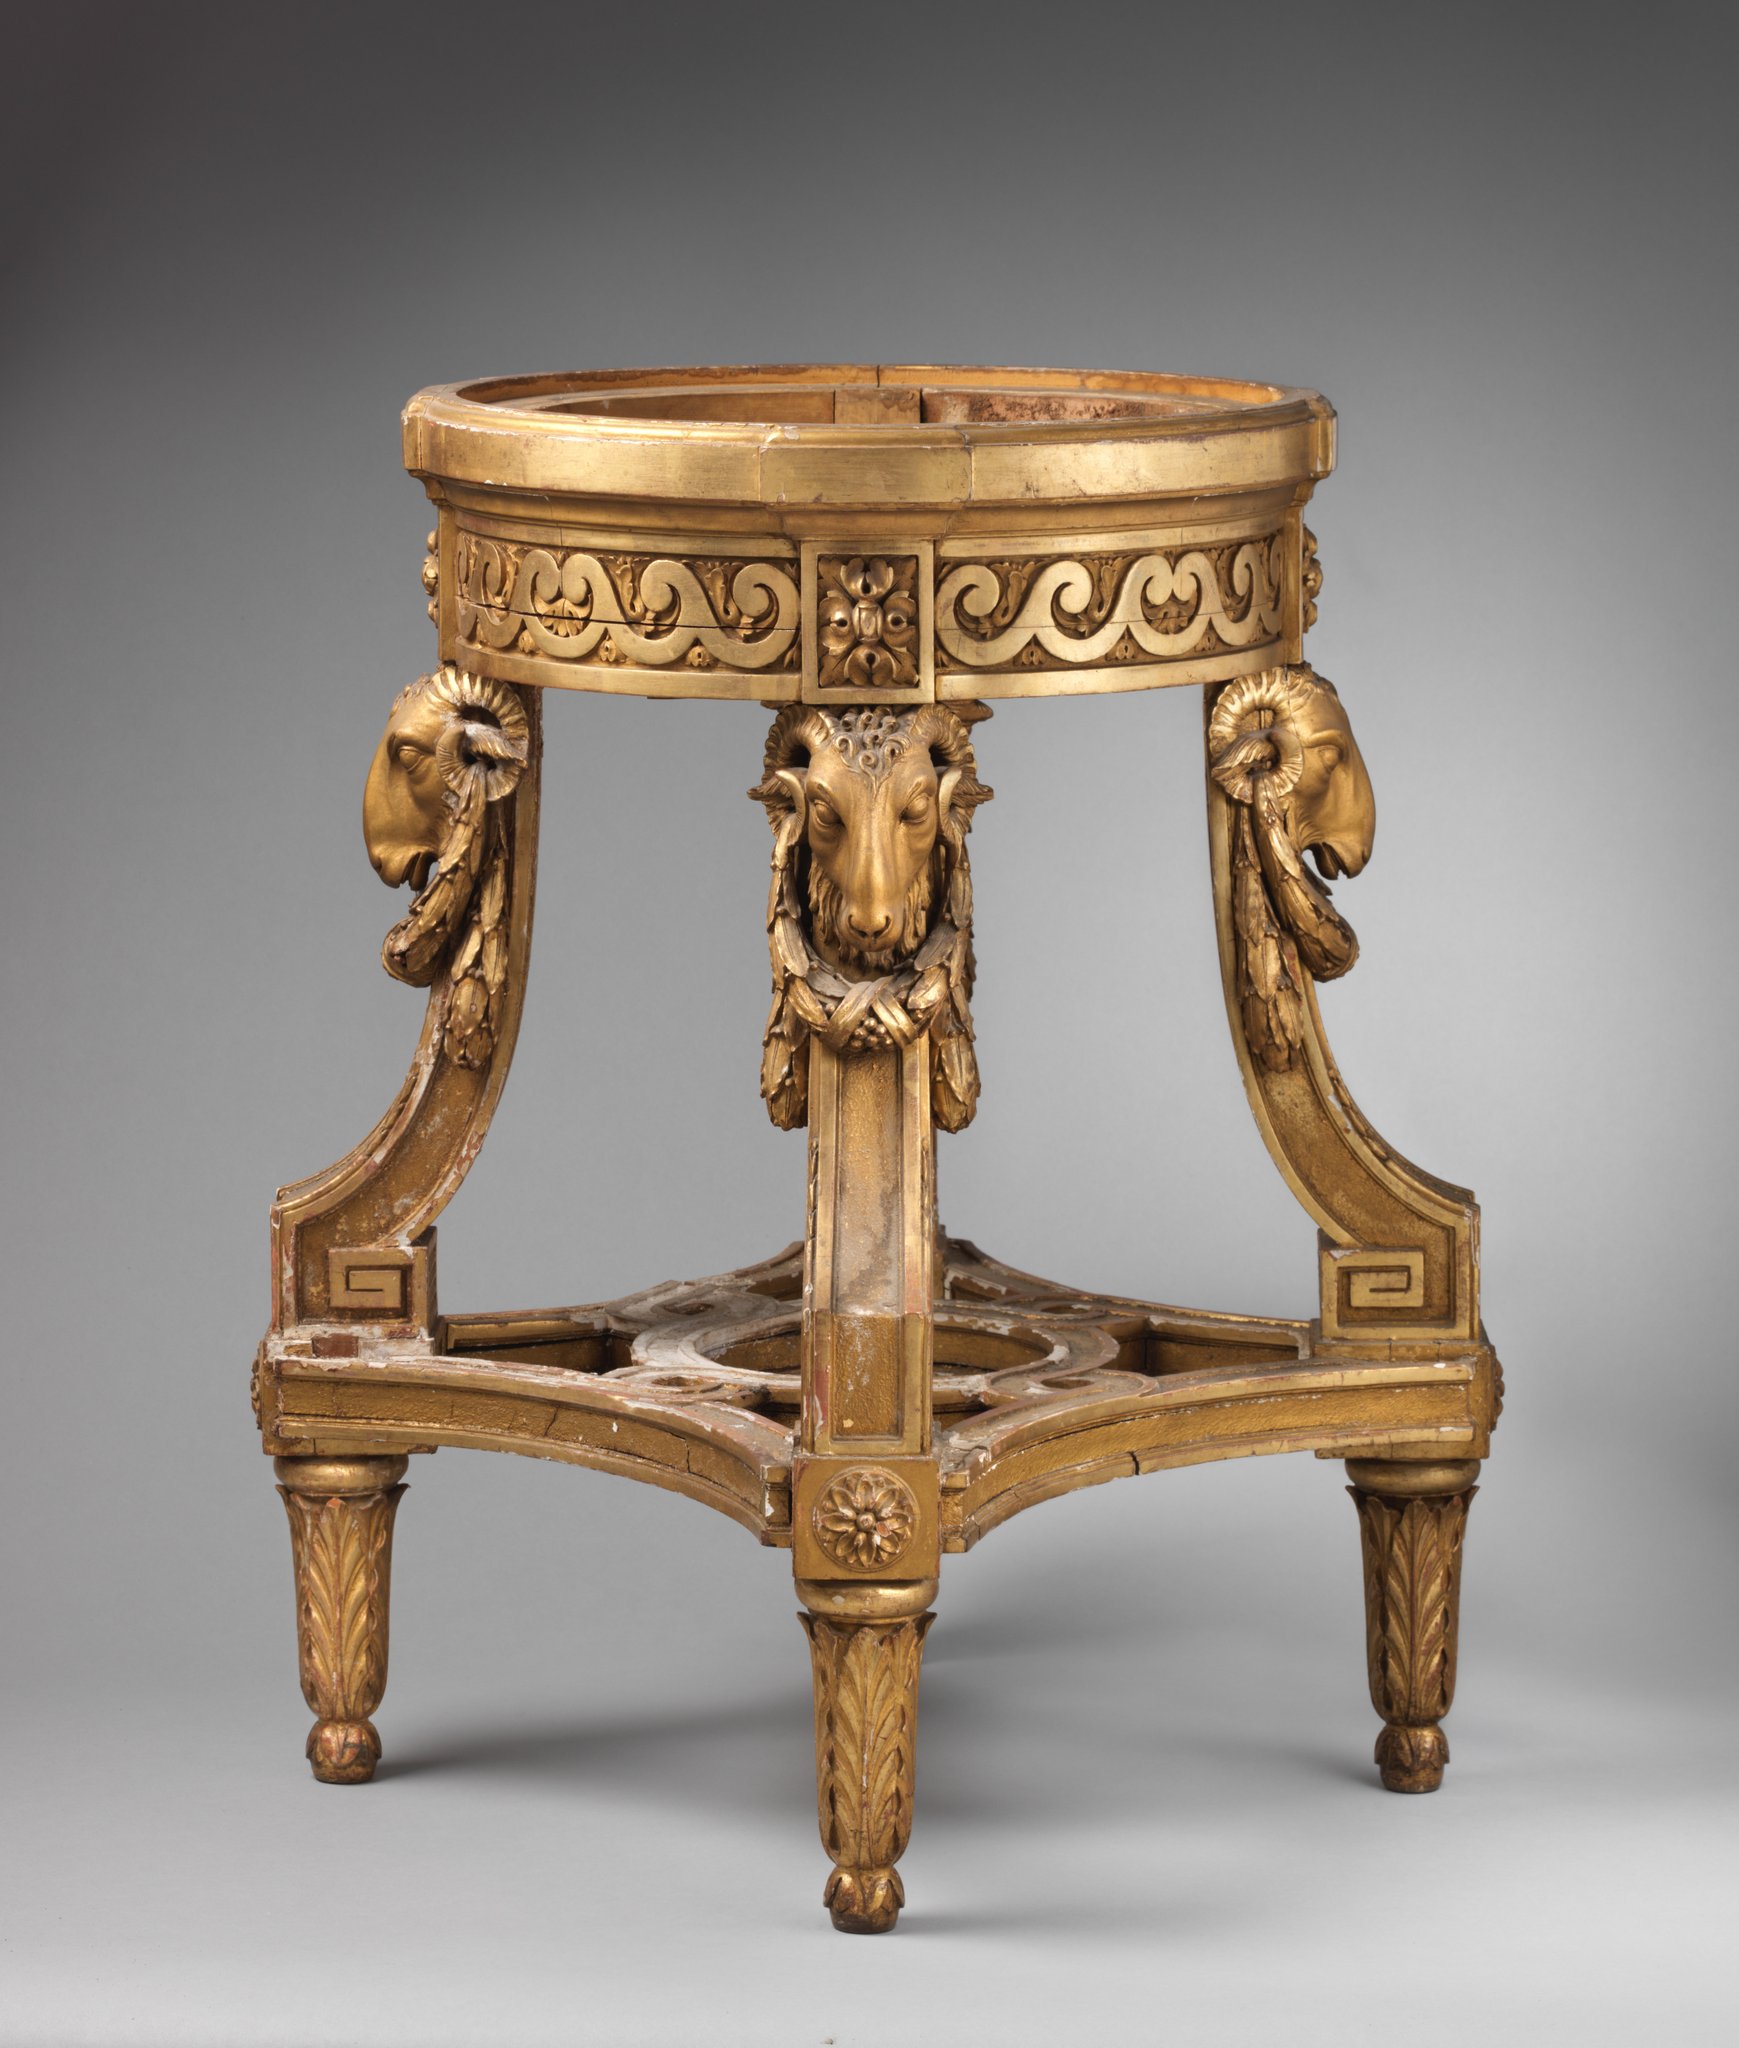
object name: vase stand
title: Vase stand with rams’ heads and carved neoclassical decoration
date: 1767-1800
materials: wood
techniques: gilding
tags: rams